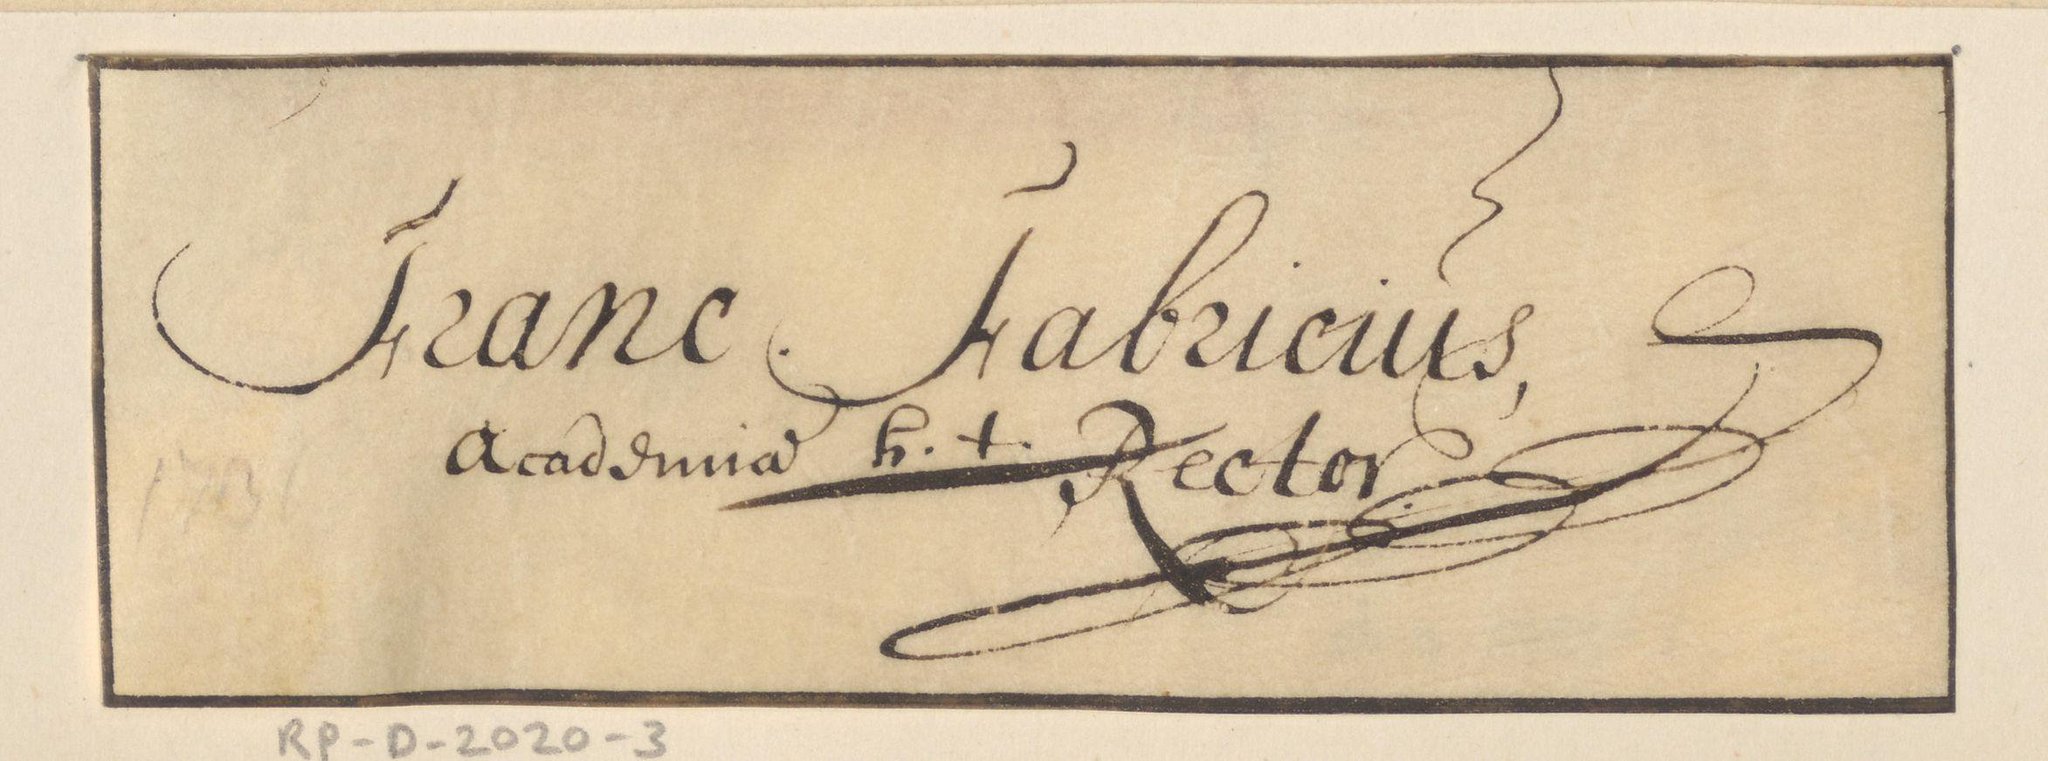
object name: document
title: Handtekening van Franciscus Fabricius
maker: franciscus fabricius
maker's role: minister, professor, theoloog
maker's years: 1663-1738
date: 1736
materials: ink, parchment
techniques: pen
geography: northern netherlands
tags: amsterdam, leiden, franciscus fabricius, historical persons